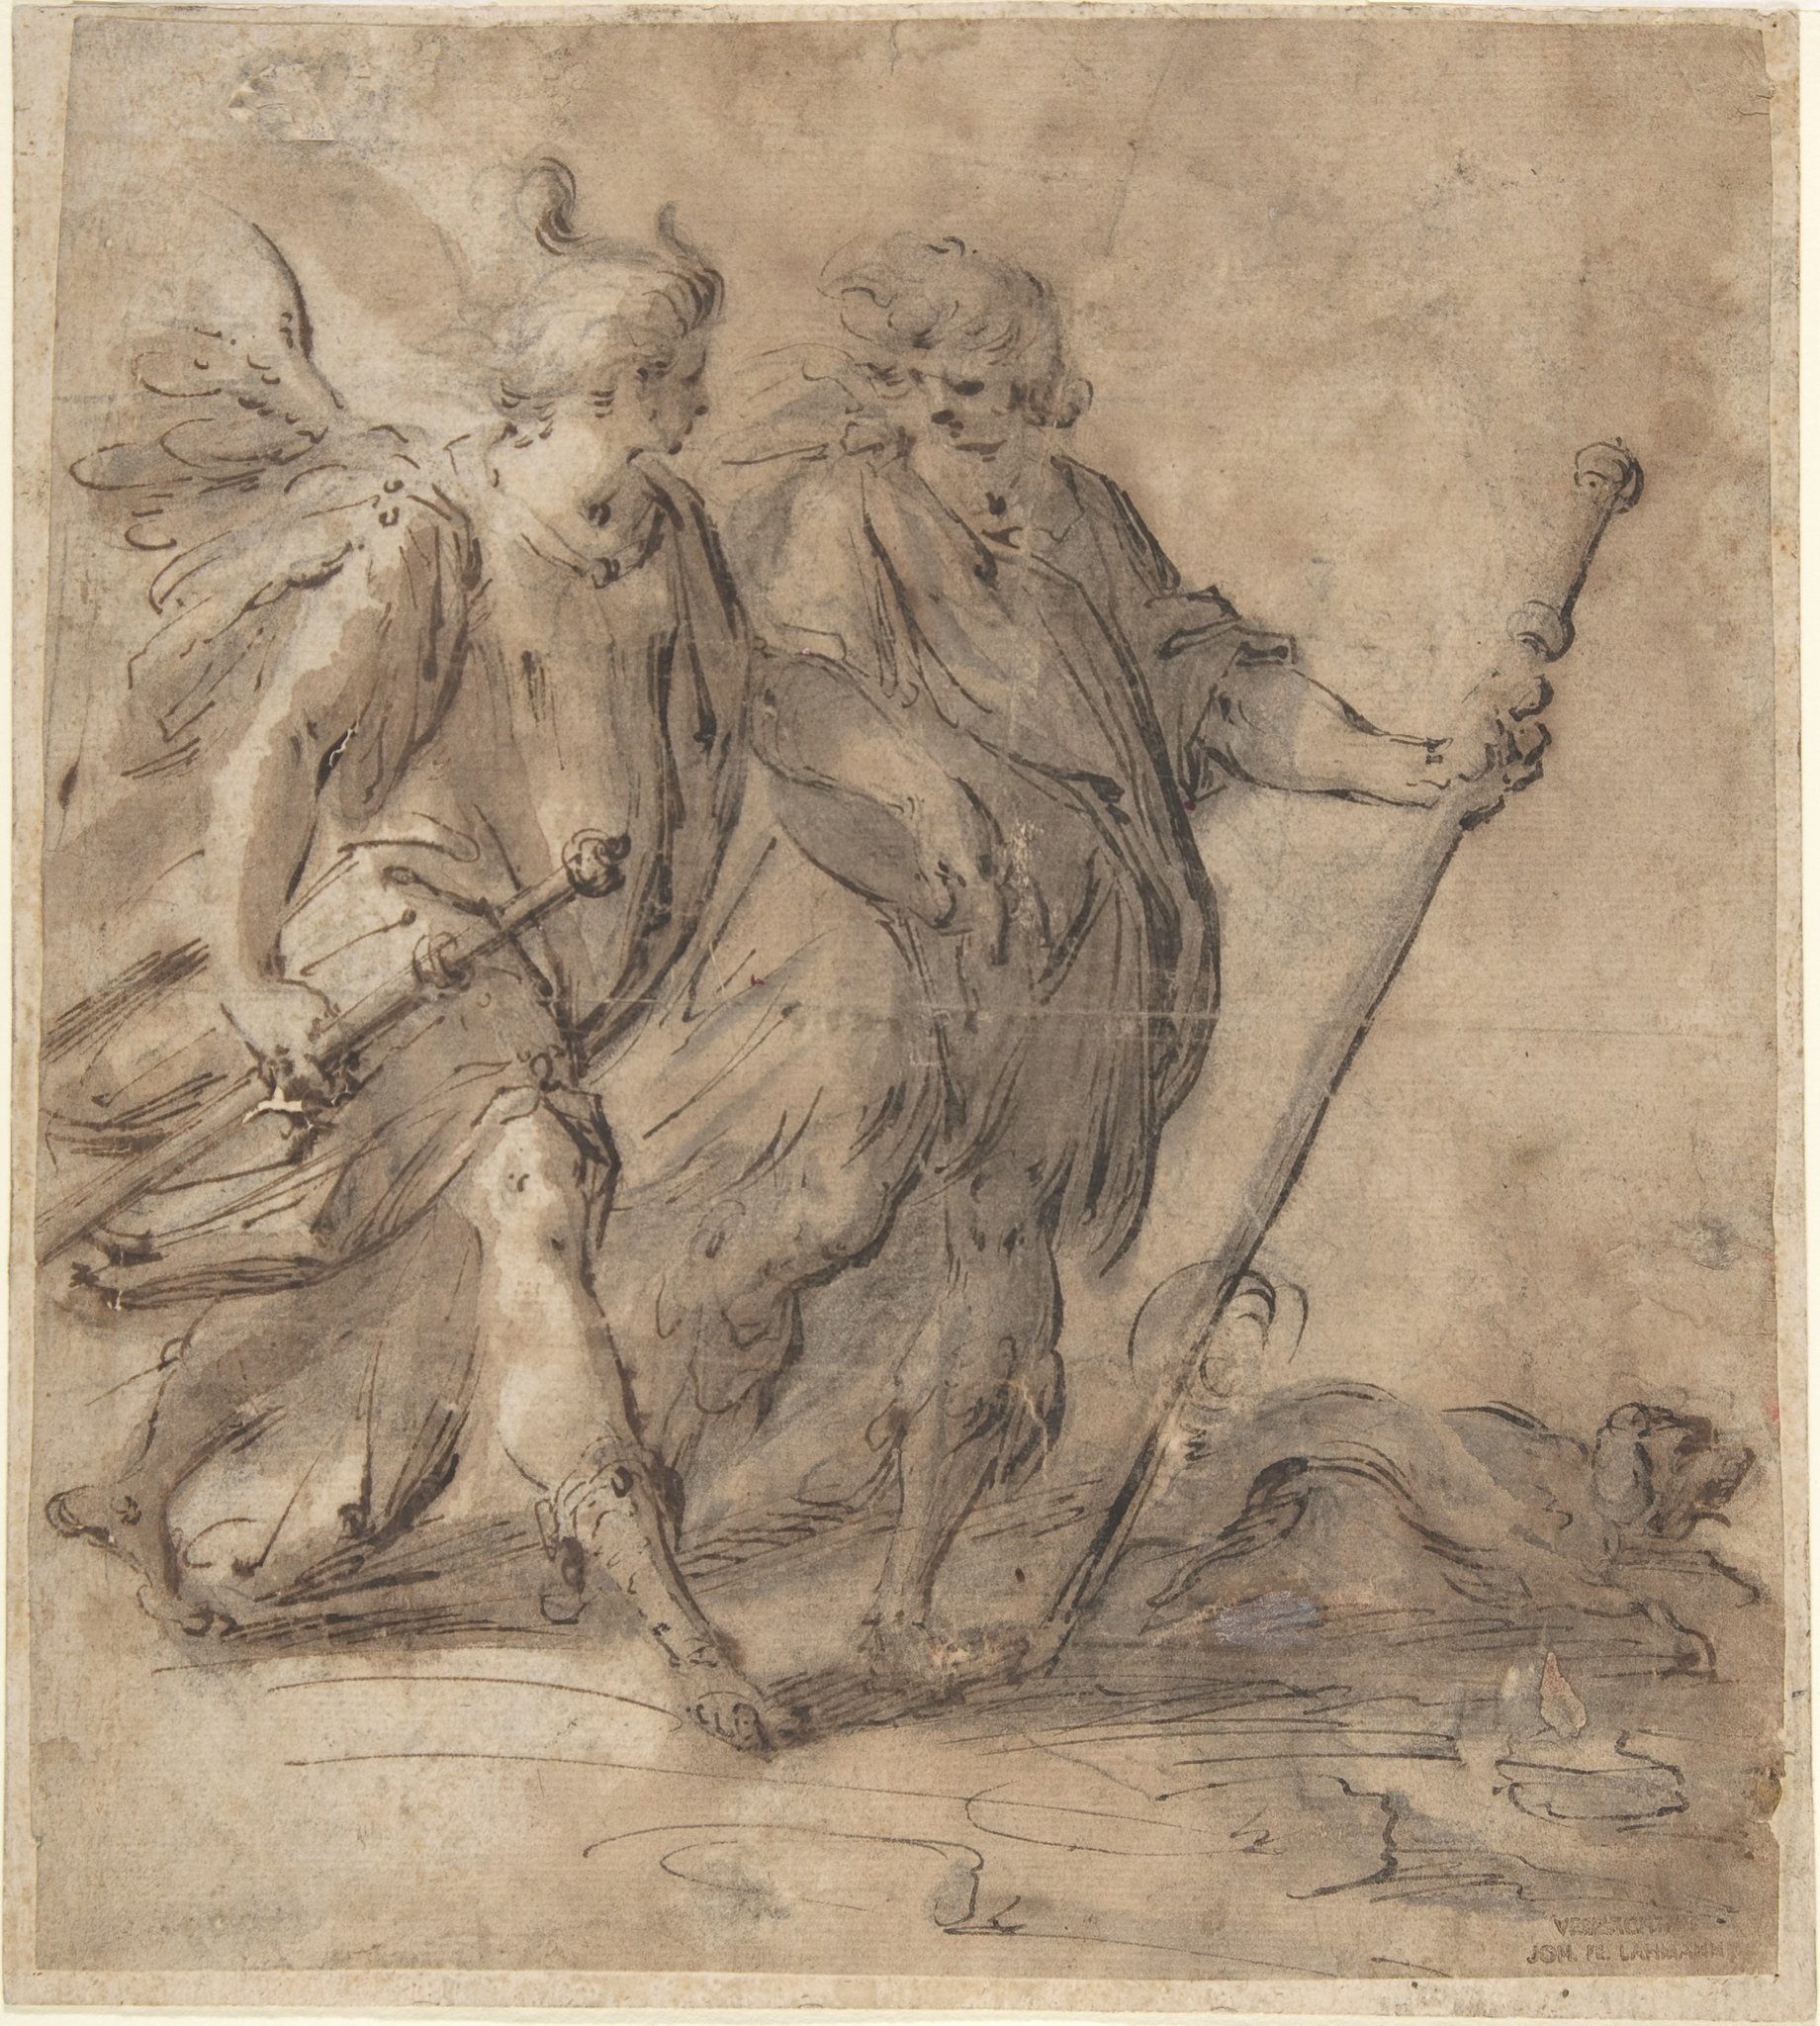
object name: drawing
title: Tobias and the Angel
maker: hans von aachen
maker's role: artist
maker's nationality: german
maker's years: 1552-1616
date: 1552-1616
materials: chalk, ink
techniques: pen, wash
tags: angels